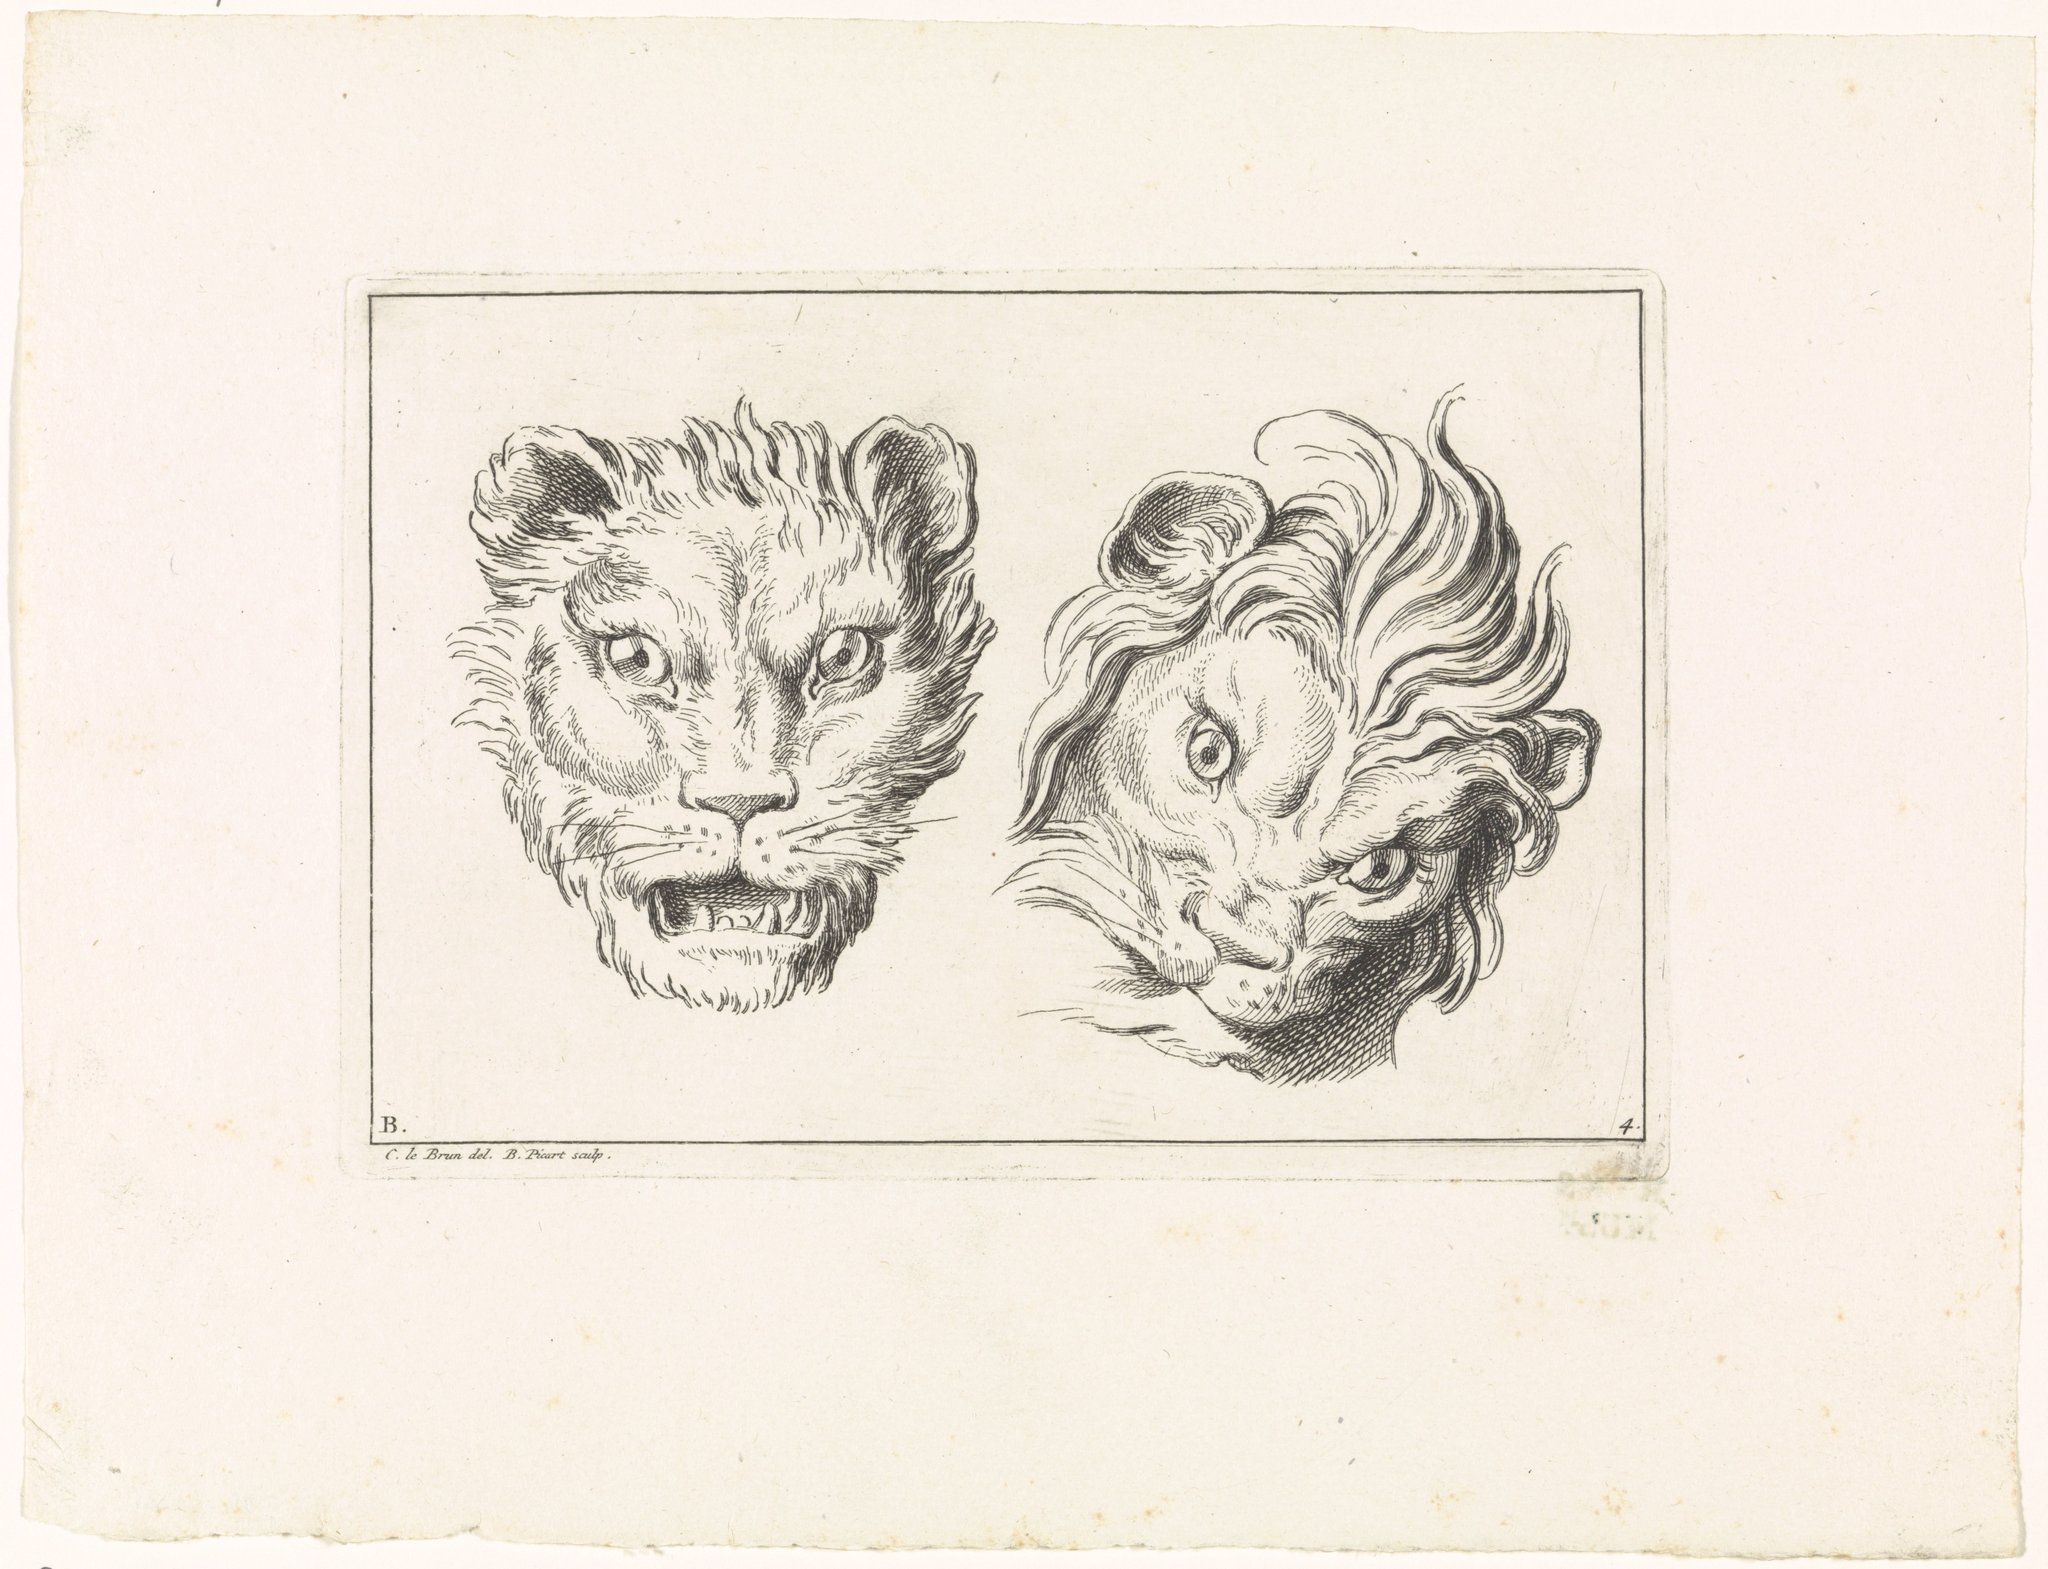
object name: print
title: Receuïl de Lions (...)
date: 1729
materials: paper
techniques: etching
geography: amsterdam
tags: beasts of prey, predatory animals: lion (+ head of an animal)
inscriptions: collector's mark: Lugt 2165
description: Prent ook als illustratie gebruikt in: Recueil de lions, dessinez d'après nature par divers maitres. Amsterdam: Bernard Picart, 1729.